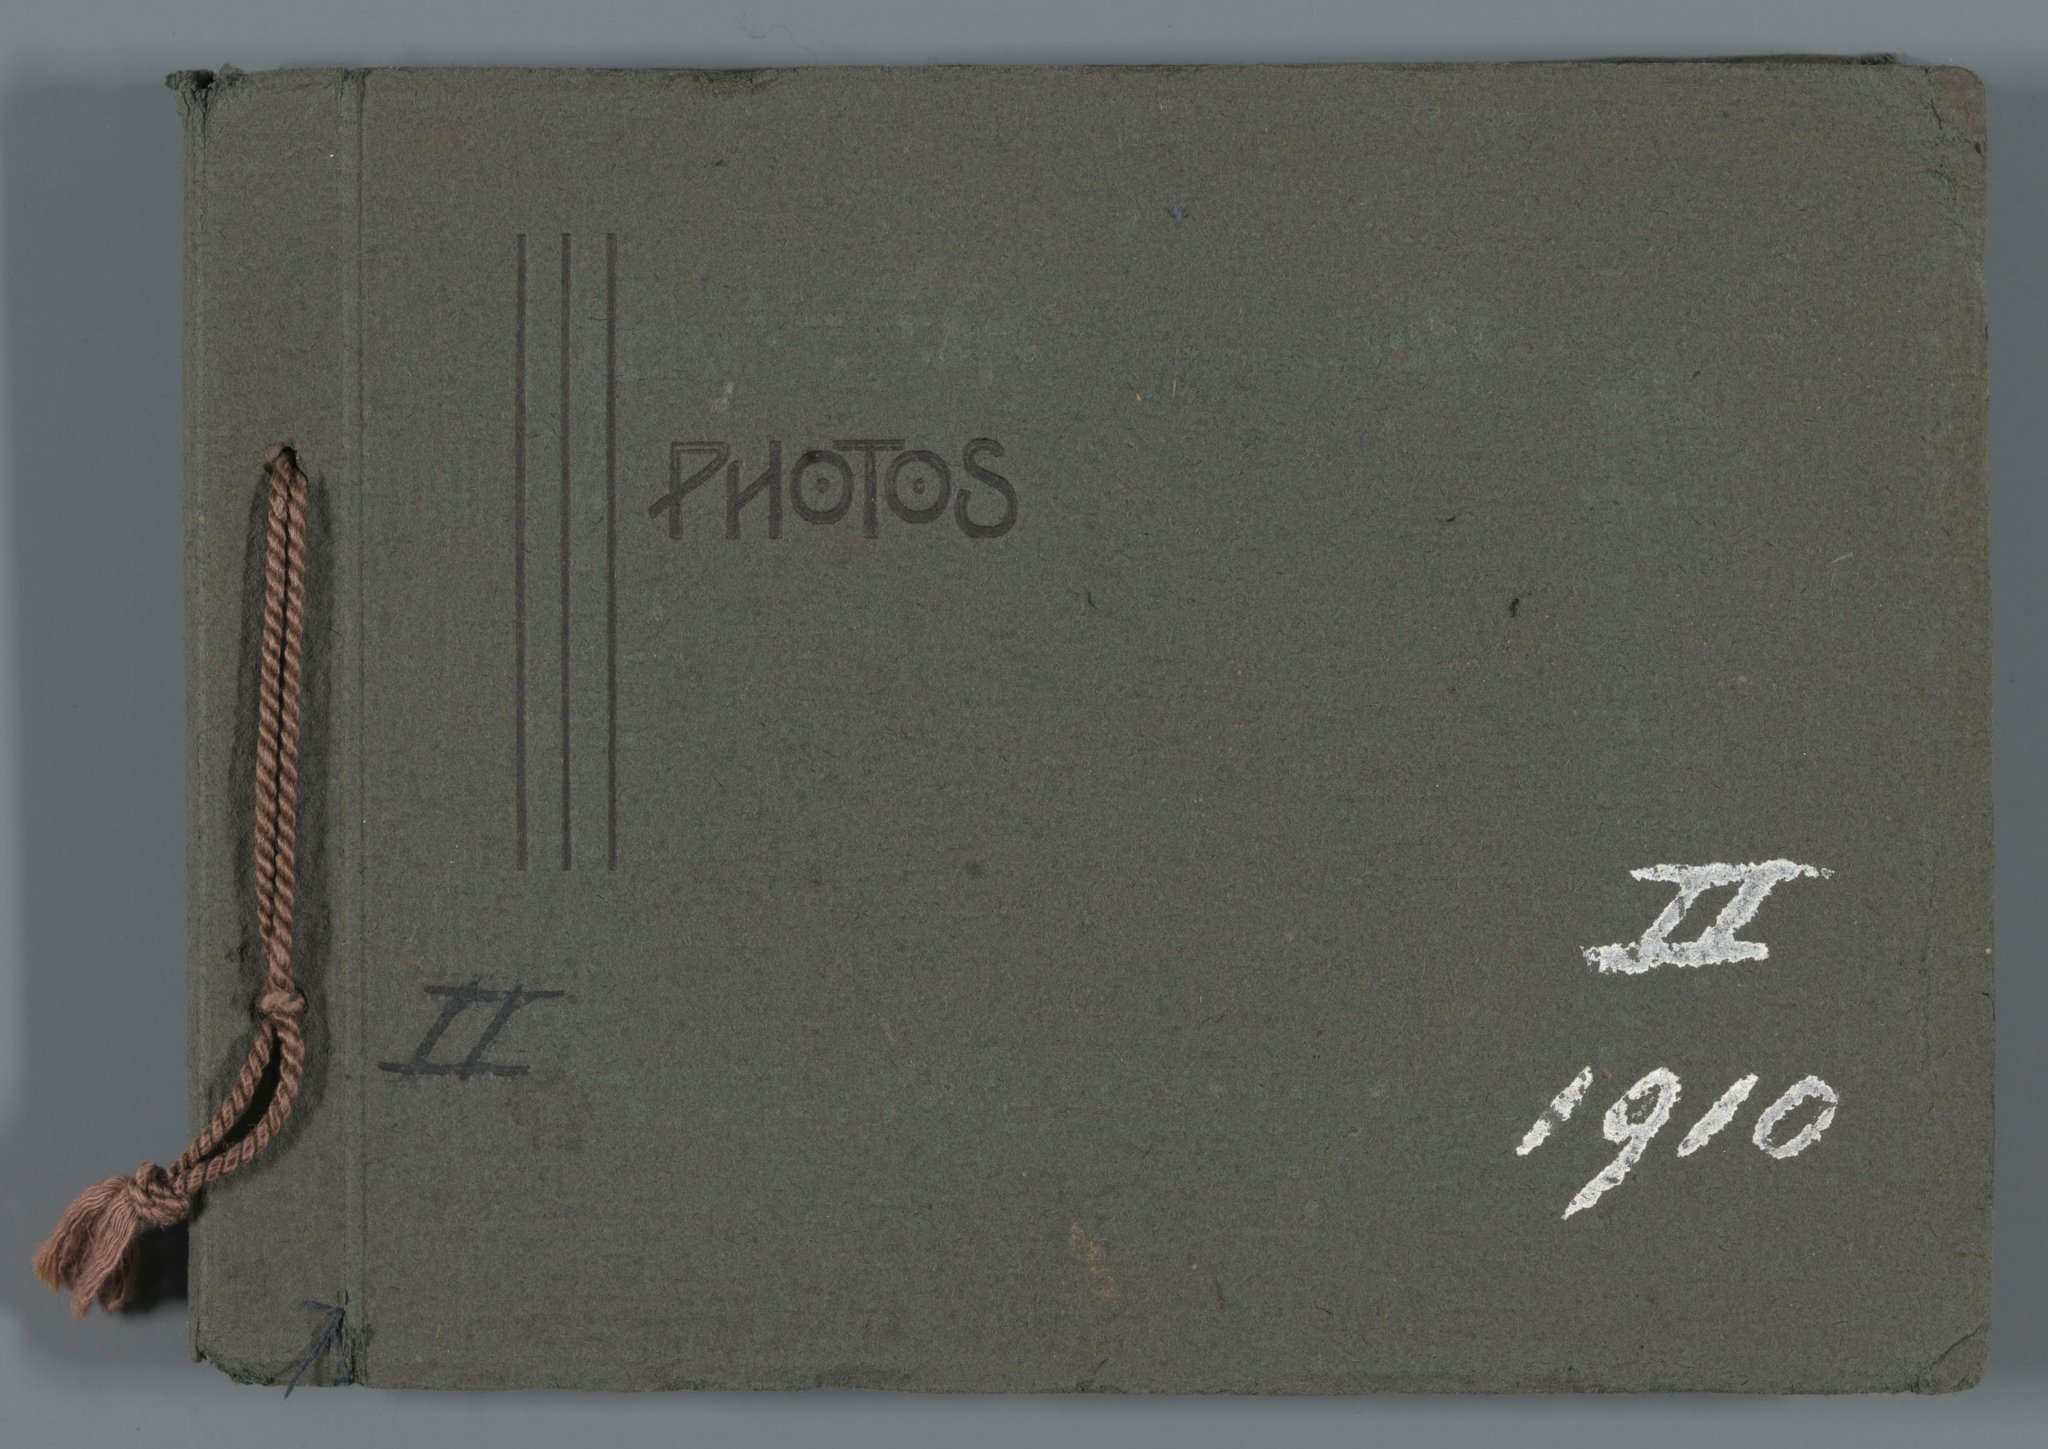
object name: slip in album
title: Fotoalbum van familie Van den Berg, 1910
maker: hendrik herman van den berg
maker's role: amateurfotograaf, jurist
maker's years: 1875-1944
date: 1910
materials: paper, cardboard, ink, fiber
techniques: carbon print, gelatin silver print, pen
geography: netherlands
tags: carel frederik van den berg (cay), historical persons, mother and baby or young child, infant, baby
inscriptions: inscription: ‘PHOTOS’, inscription: ‘II II/ 1910’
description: Insteekalbum met 26 foto's op 24 bladen. De laatste foto is op de binnenzijde van het achterplat geplakt. Het album is vermoedelijk gefotografeerd en samengesteld door Hendrik Herman van den Berg. Het album bevat foto's van het eerste levensjaar van Cay van den Berg.